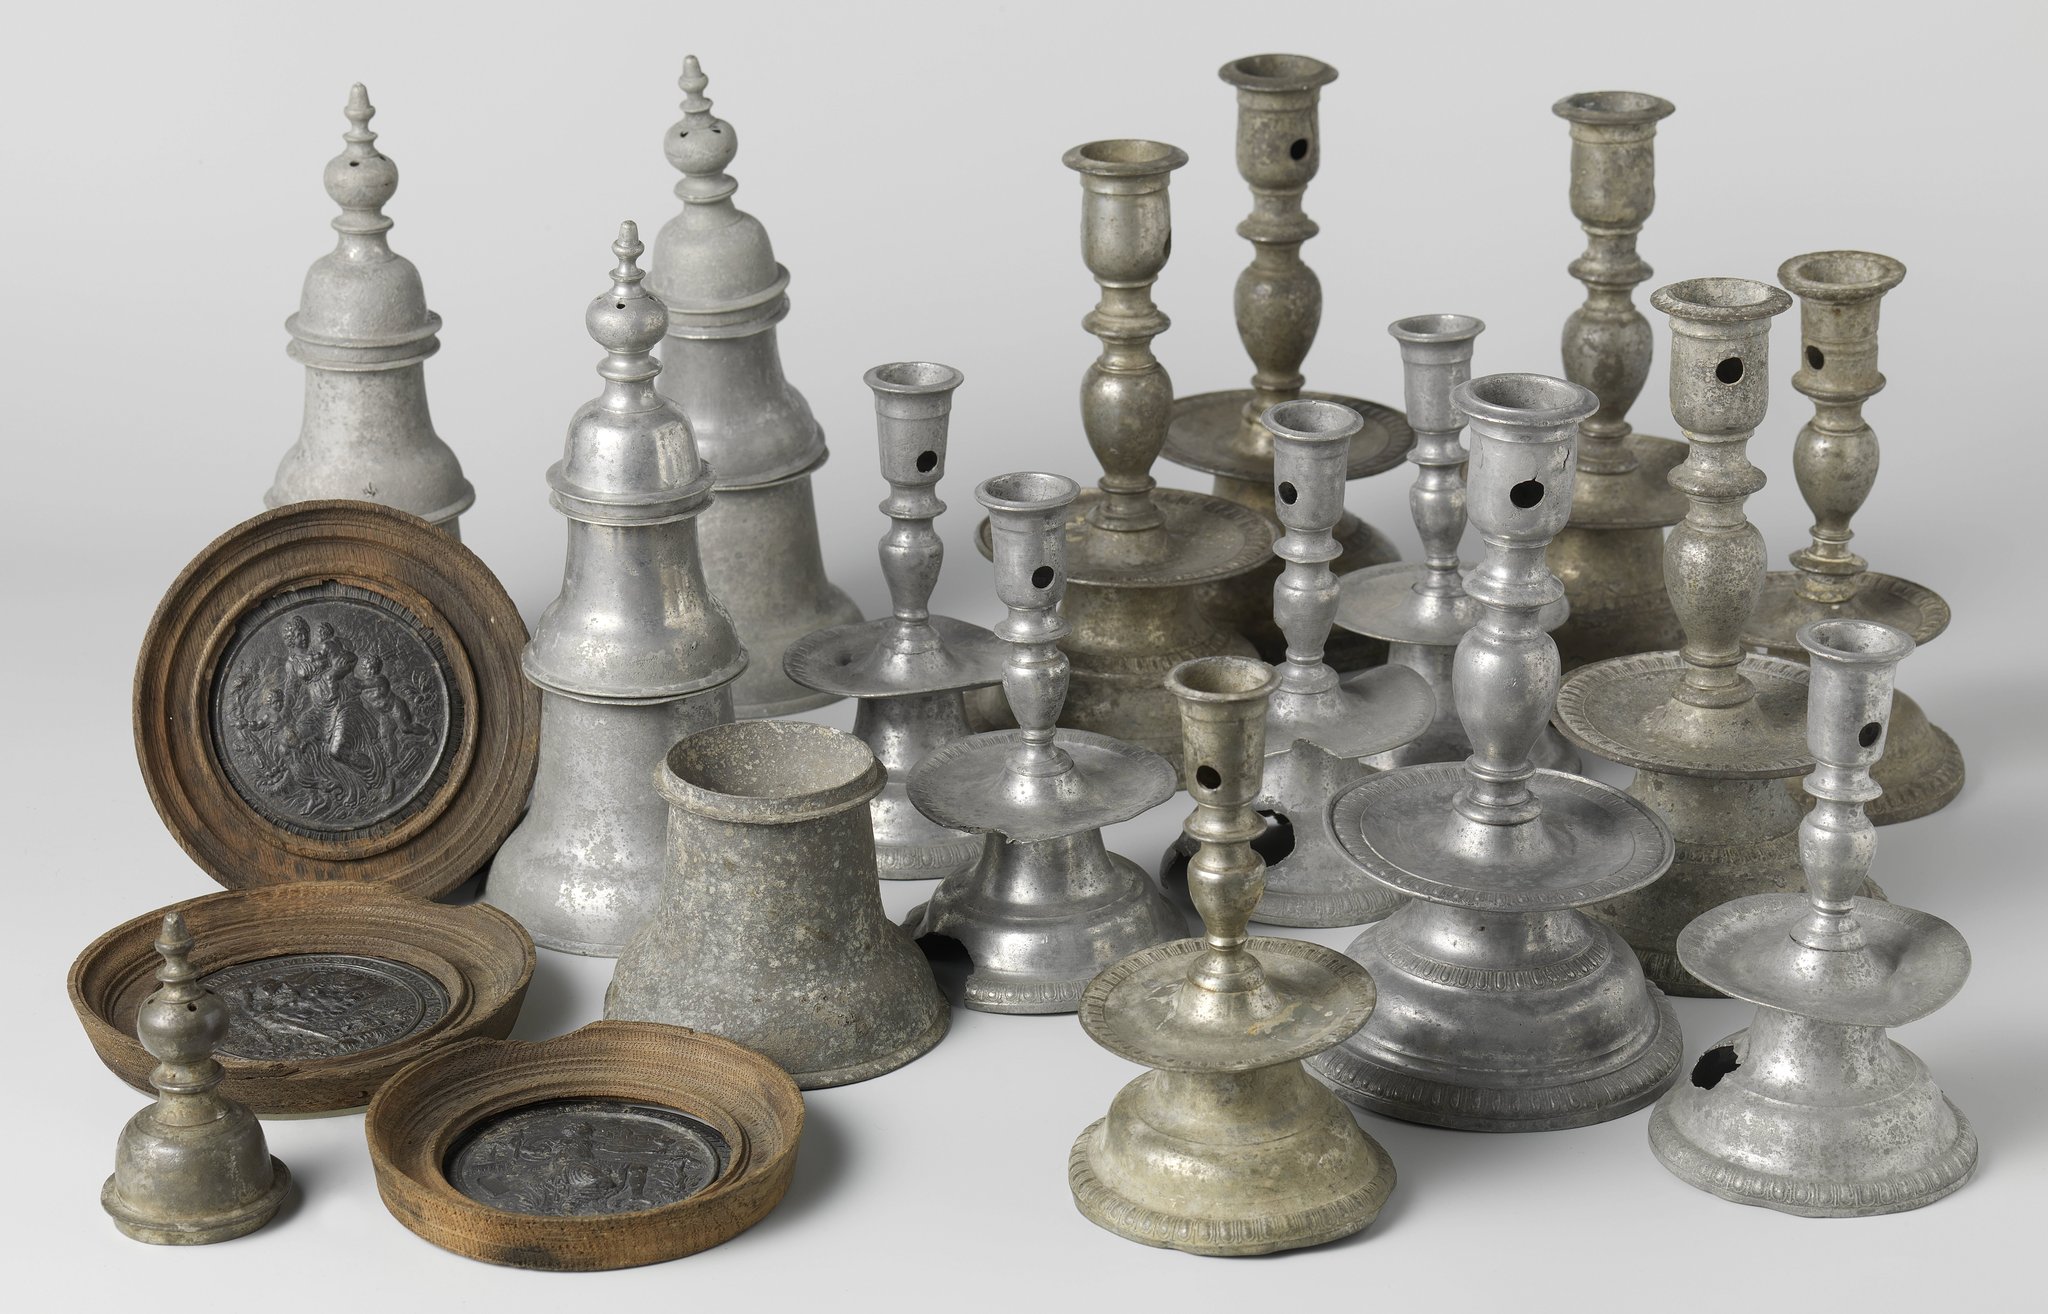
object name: candlestick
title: Klokkandelaar, vierdelig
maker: Anonymous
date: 1590-1596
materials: tin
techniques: casting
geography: netherlands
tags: willem barendsz., amsterdam, jacob van heemskerck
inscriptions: mark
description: Tin/Pewter candlesticks